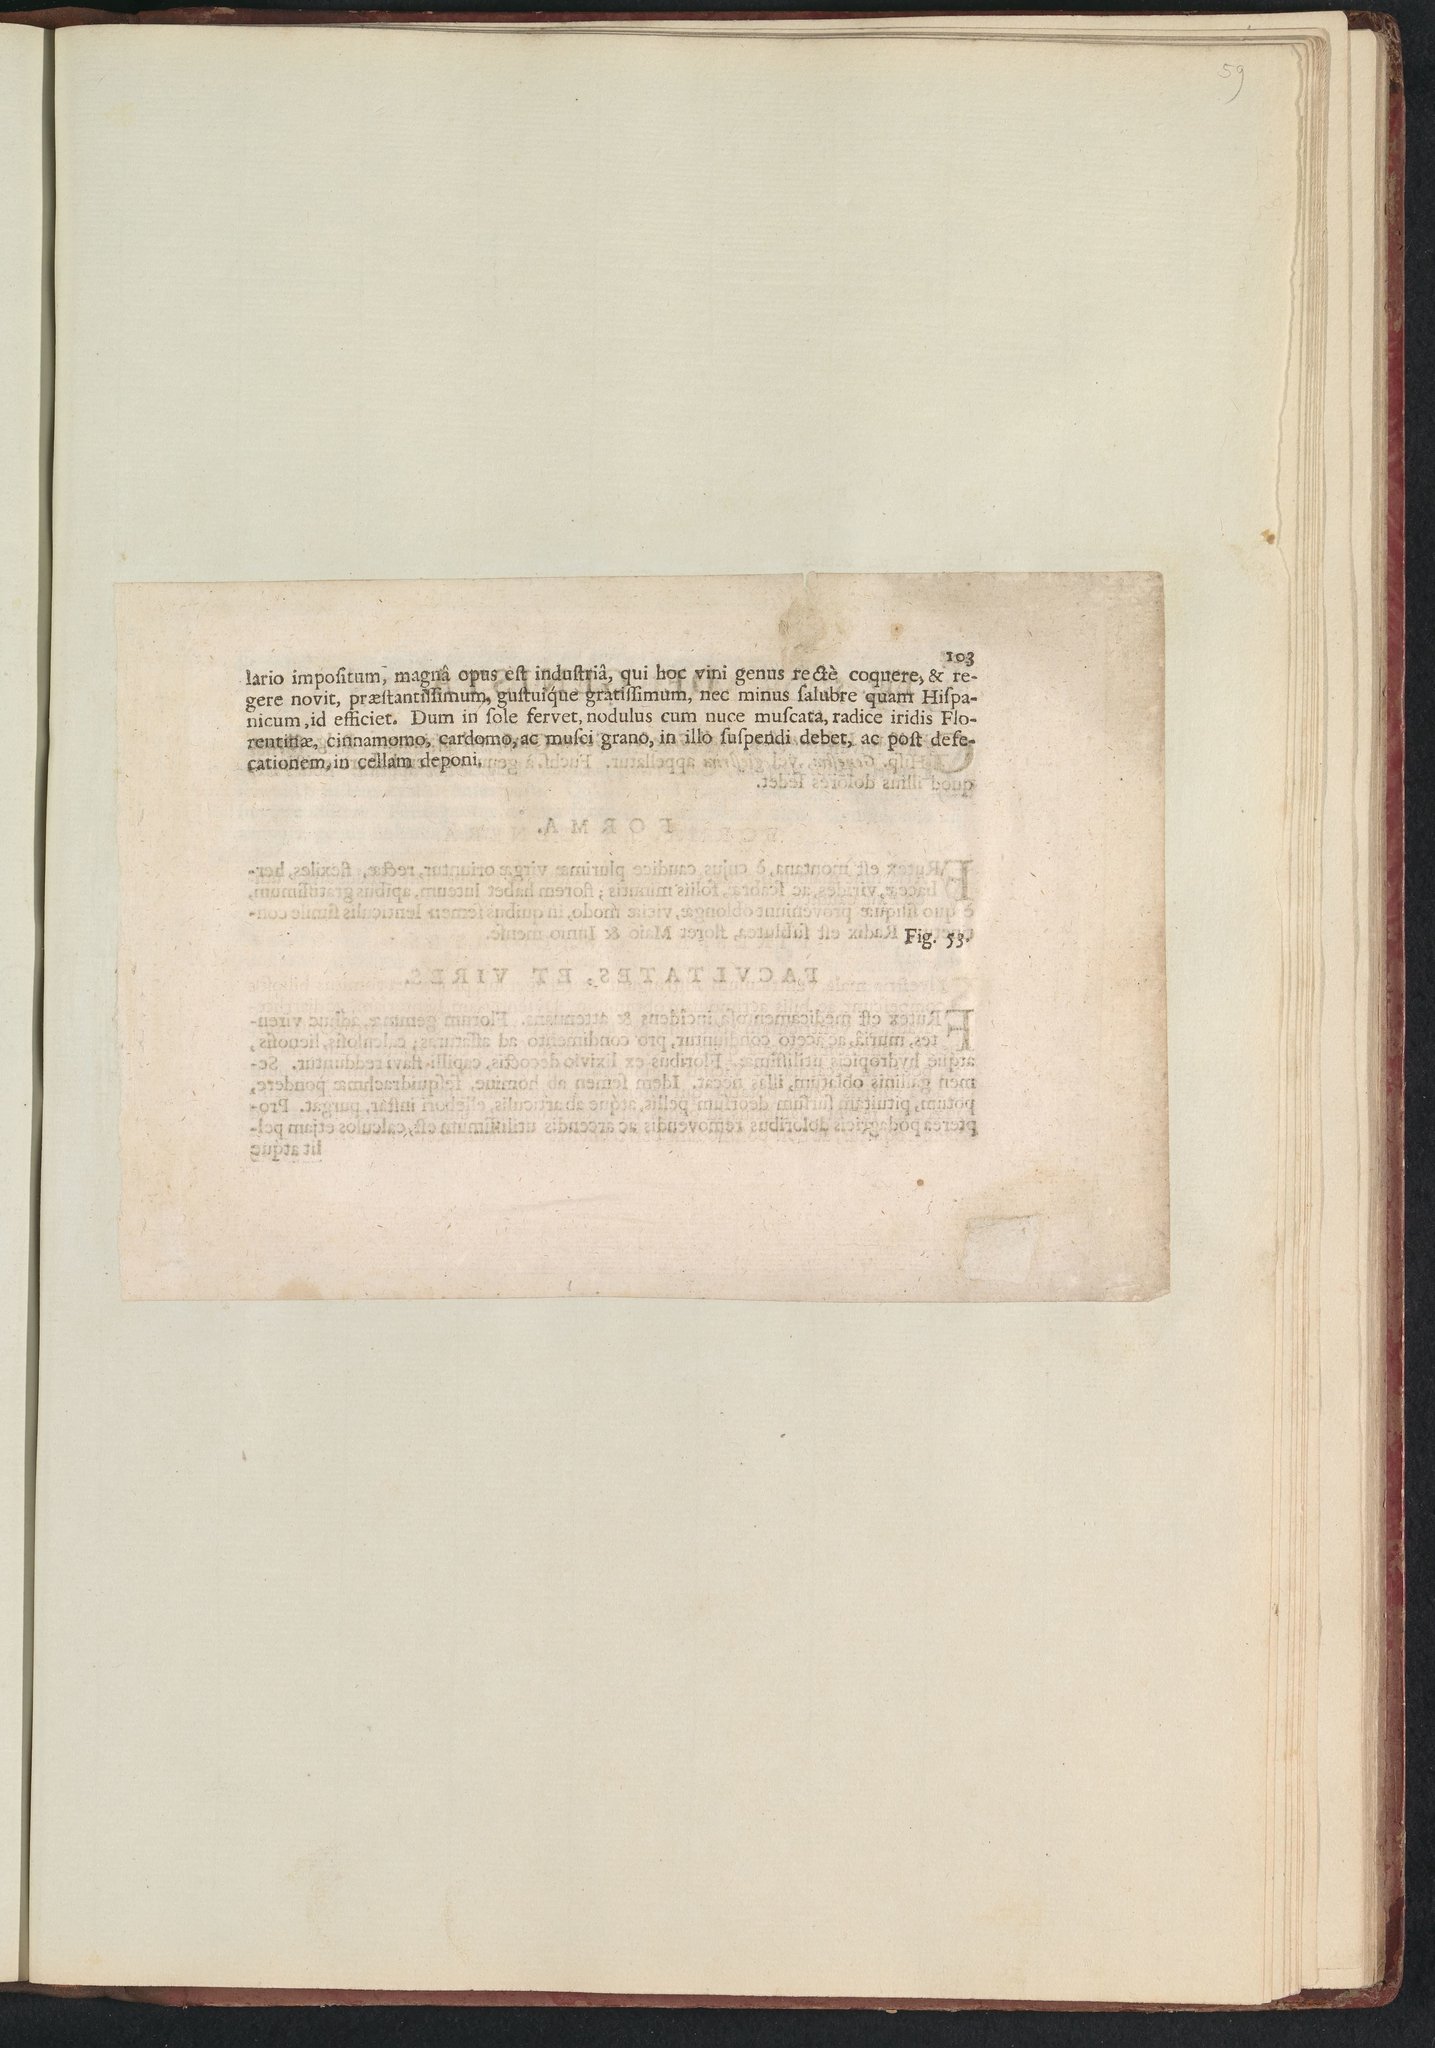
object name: text sheet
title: Fig. 52 'De Malis Sylvestribus' in De Boodts herbarium van 1640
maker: anselmus boëtius de boodt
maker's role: draughtsman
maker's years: 1550-1632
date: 1640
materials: ink, paper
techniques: letterpress printing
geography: bruges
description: Beschrijving bij Fig. 52 op p. 103 in: Anselmi Boëtii de Boot I.C. Brugensis & Rodolphi II. Imp. Roman. medici a cubiculis Florum, Herbarum, ac fructuum selectiorum icones, & vires pleraeque hactenus ignotæ. Onderdeel van het album met bladen en platen uit De Boodts herbarium van 1640. Het twaalfde van twaalf albums met aquarellen van dieren, vogels en planten bekend rond 1600, gemaakt in opdracht van keizer Rudolf II.